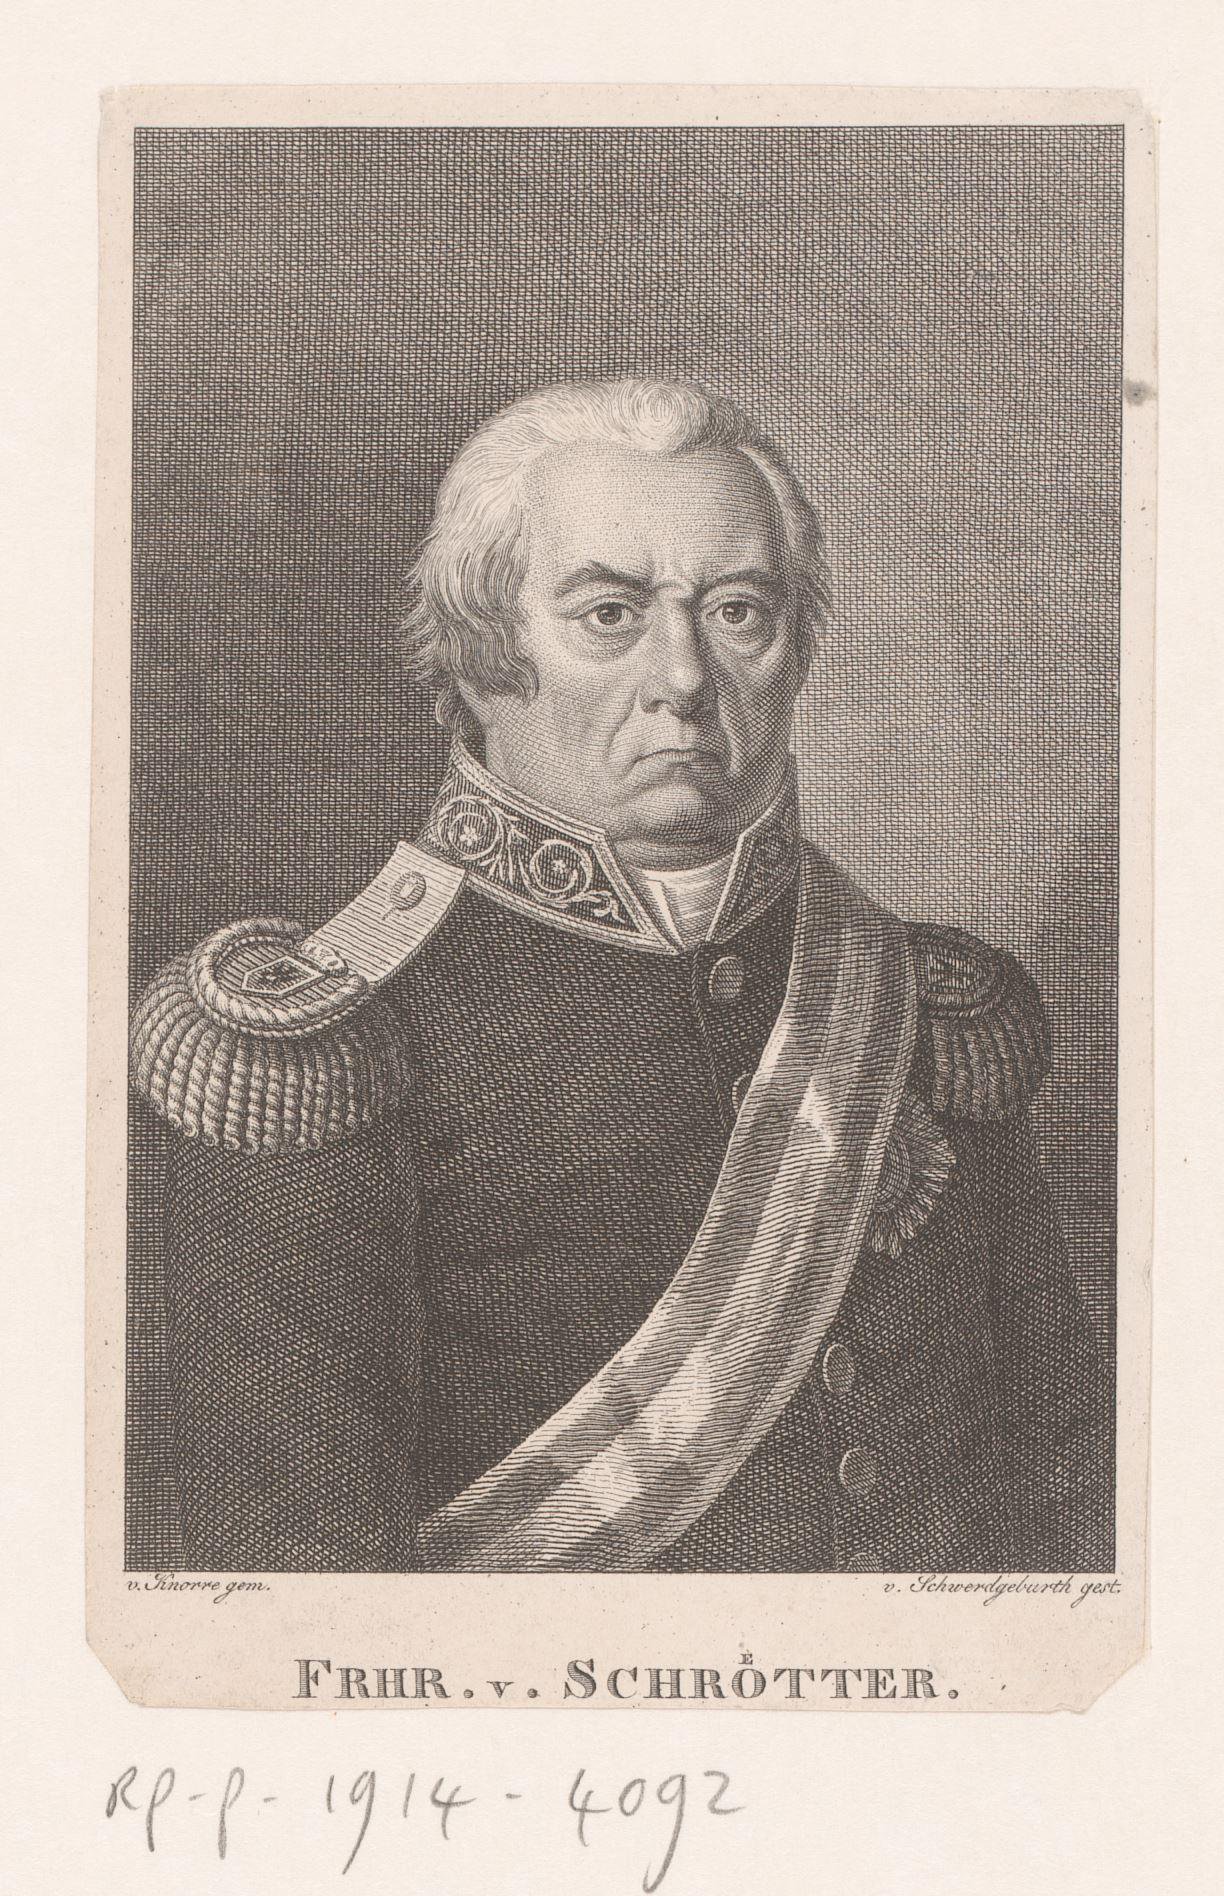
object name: print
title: Portret van Friedrich Leopold, Freiherr von Schrötter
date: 1795-1878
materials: paper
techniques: engraving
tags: historical persons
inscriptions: collector's mark: Lugt 2228